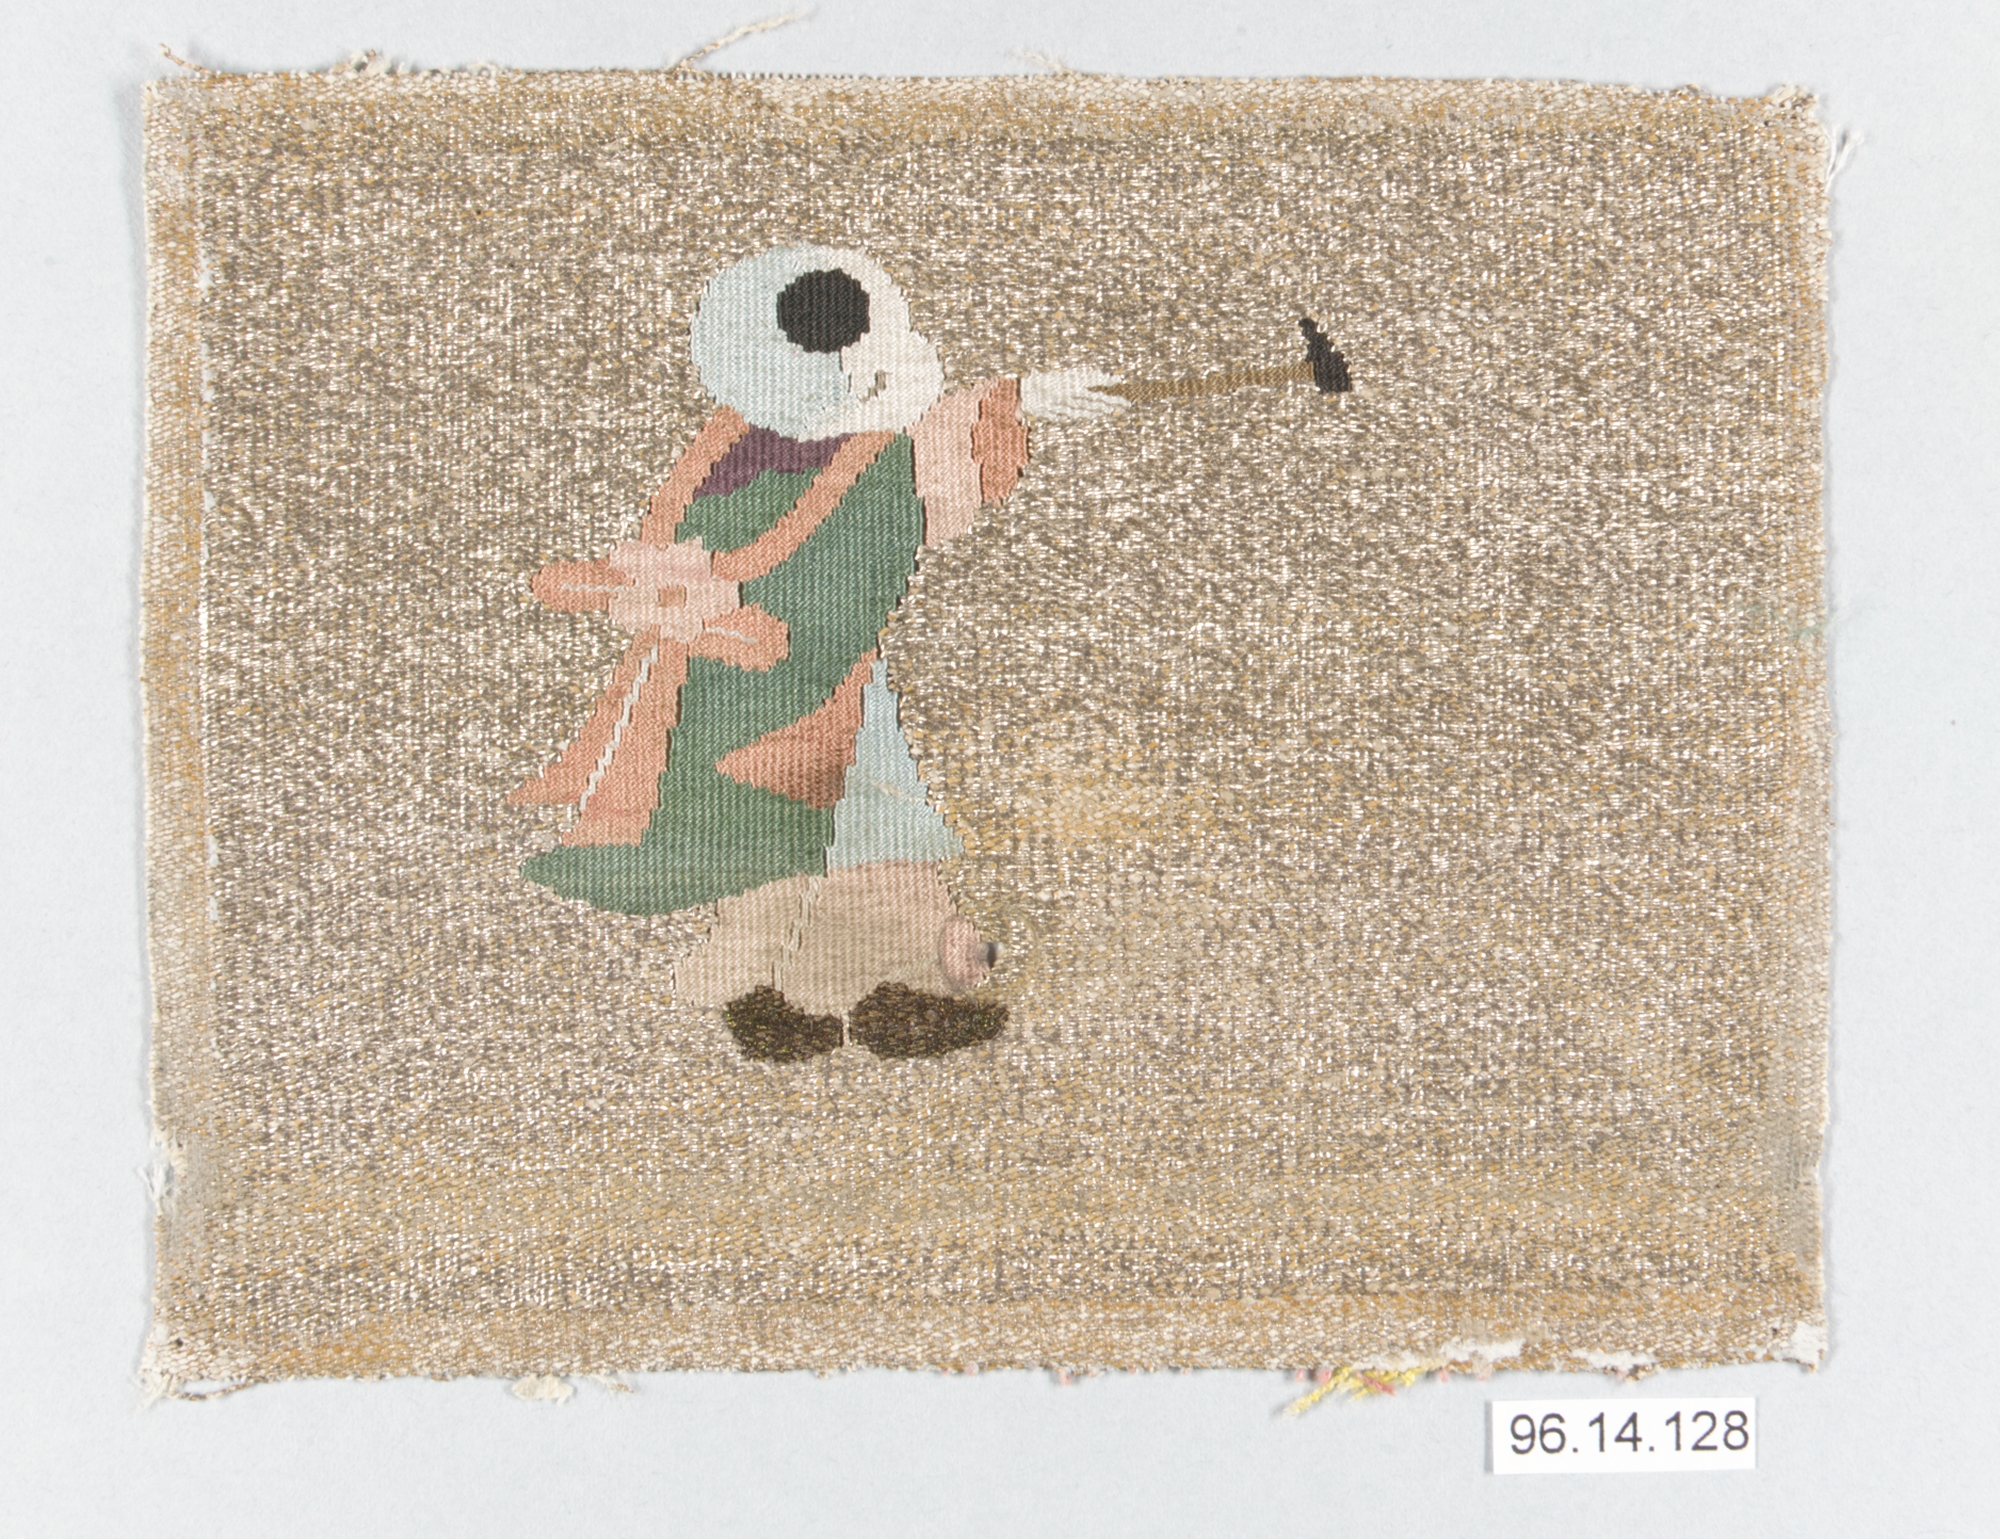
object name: piece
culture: japanese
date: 1701-1900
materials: silk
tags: boys